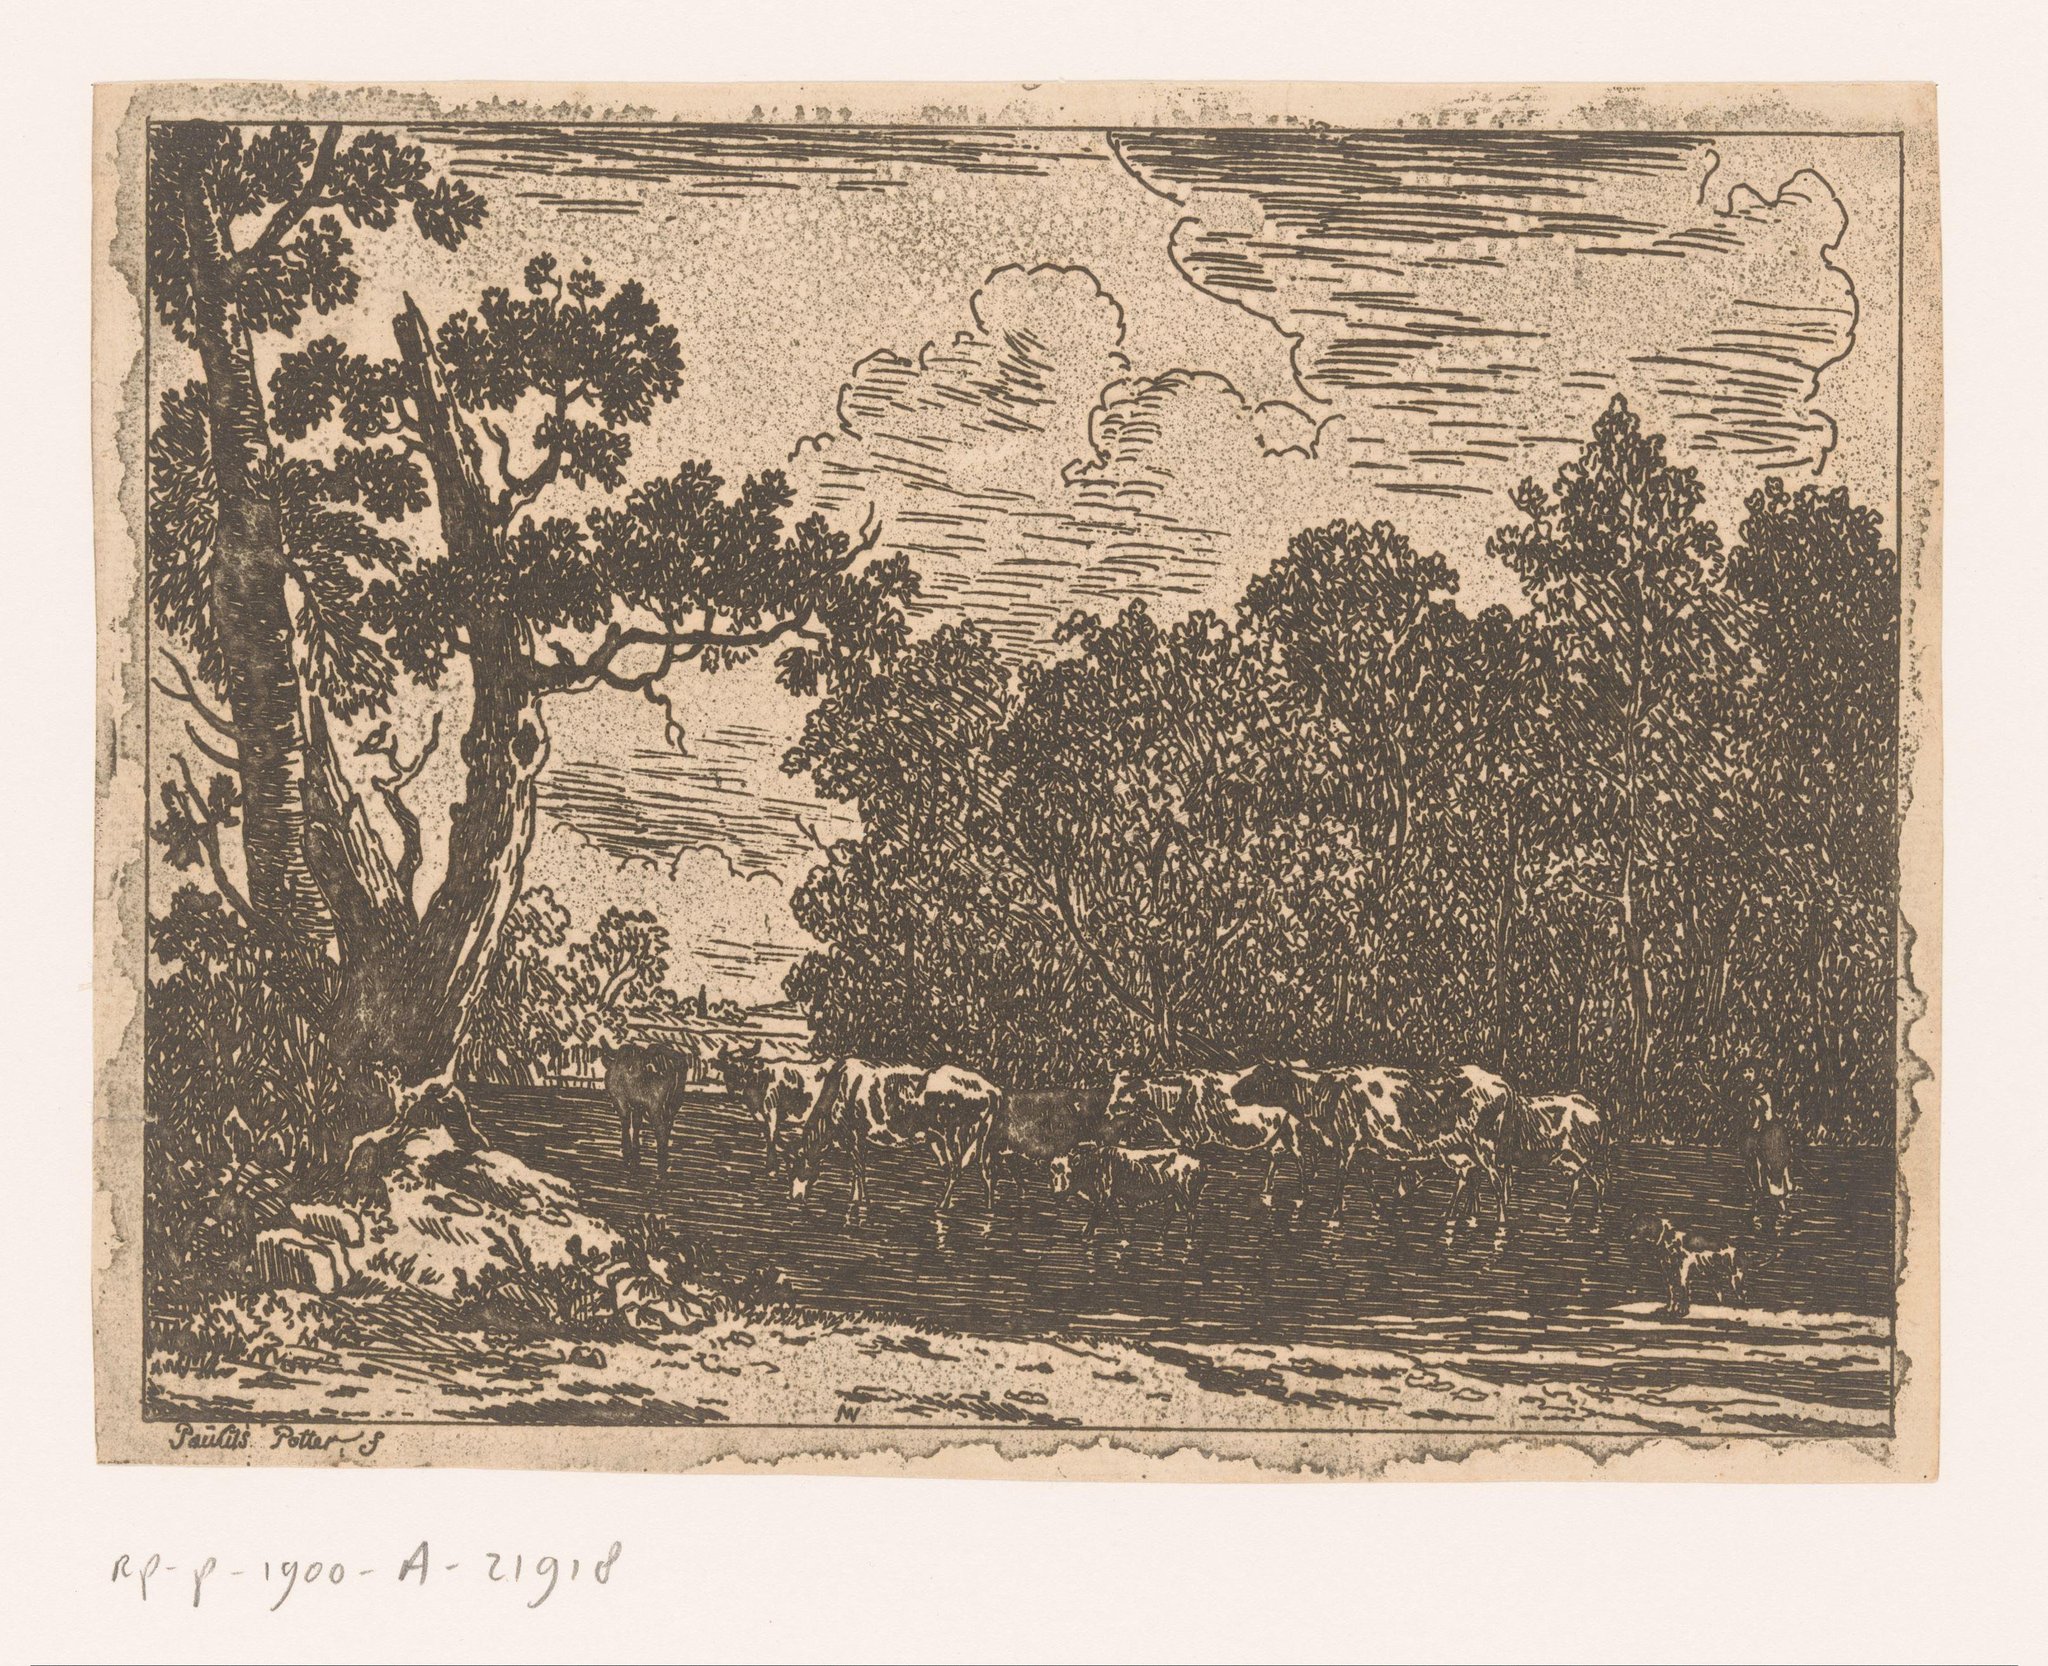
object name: print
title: Landschap met vee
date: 1635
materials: paper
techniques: etching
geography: germany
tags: dog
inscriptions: collector's mark: Lugt 2228